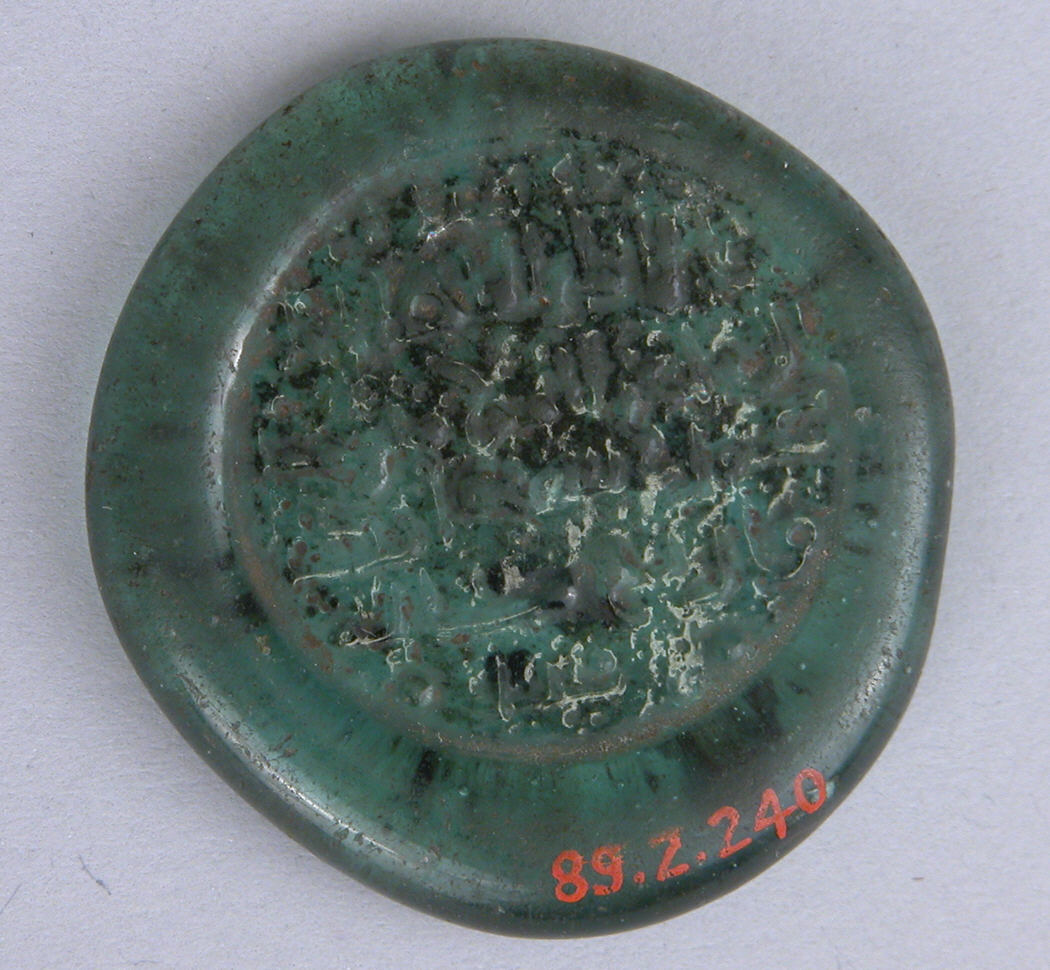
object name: coin weight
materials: glass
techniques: stamping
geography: egypt